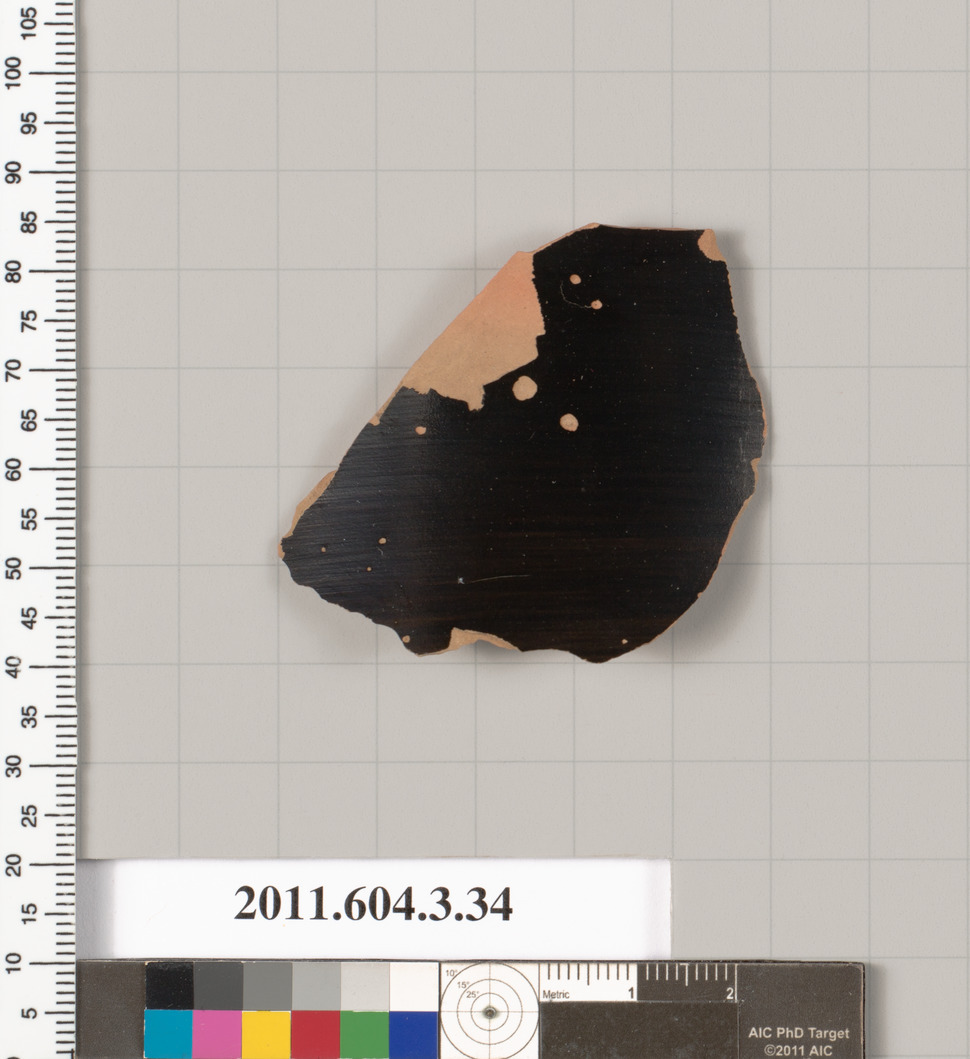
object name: amphora fragment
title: Terracotta fragment of an amphora (jar)?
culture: greek, attic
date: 600-501 BCE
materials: terracotta